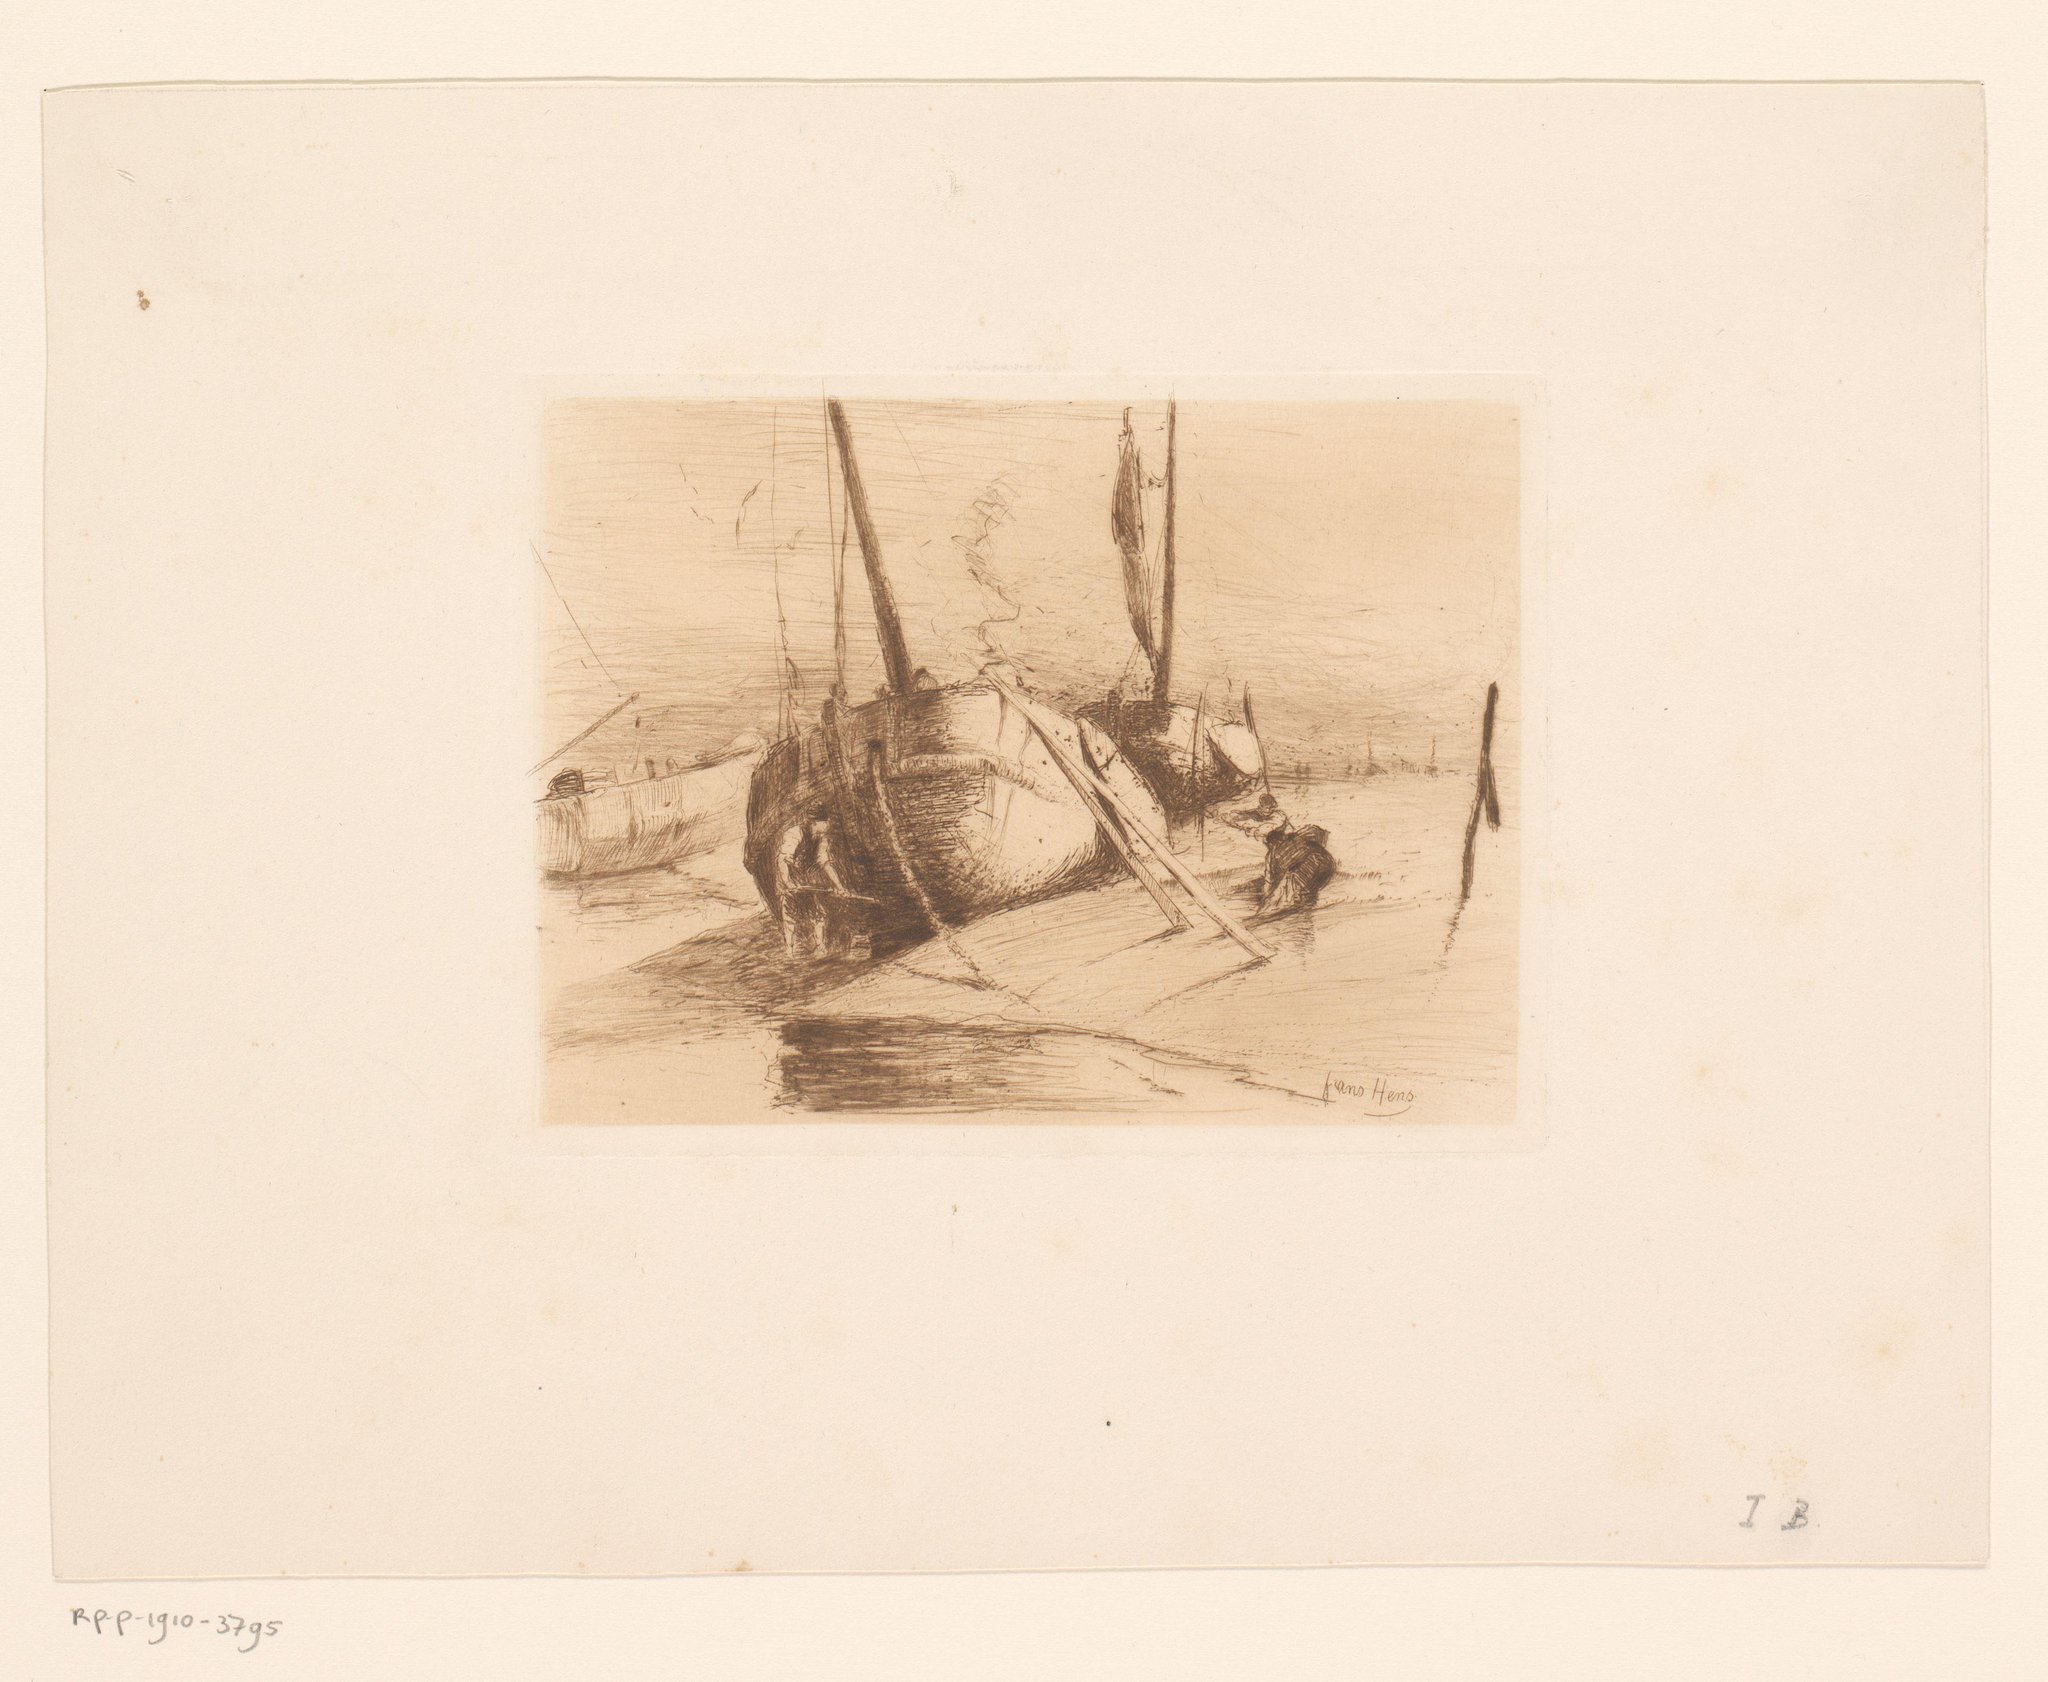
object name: print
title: Schepen worden op het strand getrokken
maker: frans hens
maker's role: print maker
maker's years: 1856-1928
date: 1866-1910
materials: paper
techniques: etching, intaglio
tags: ships, boats on land, beached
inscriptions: collector's mark: Lugt 2228